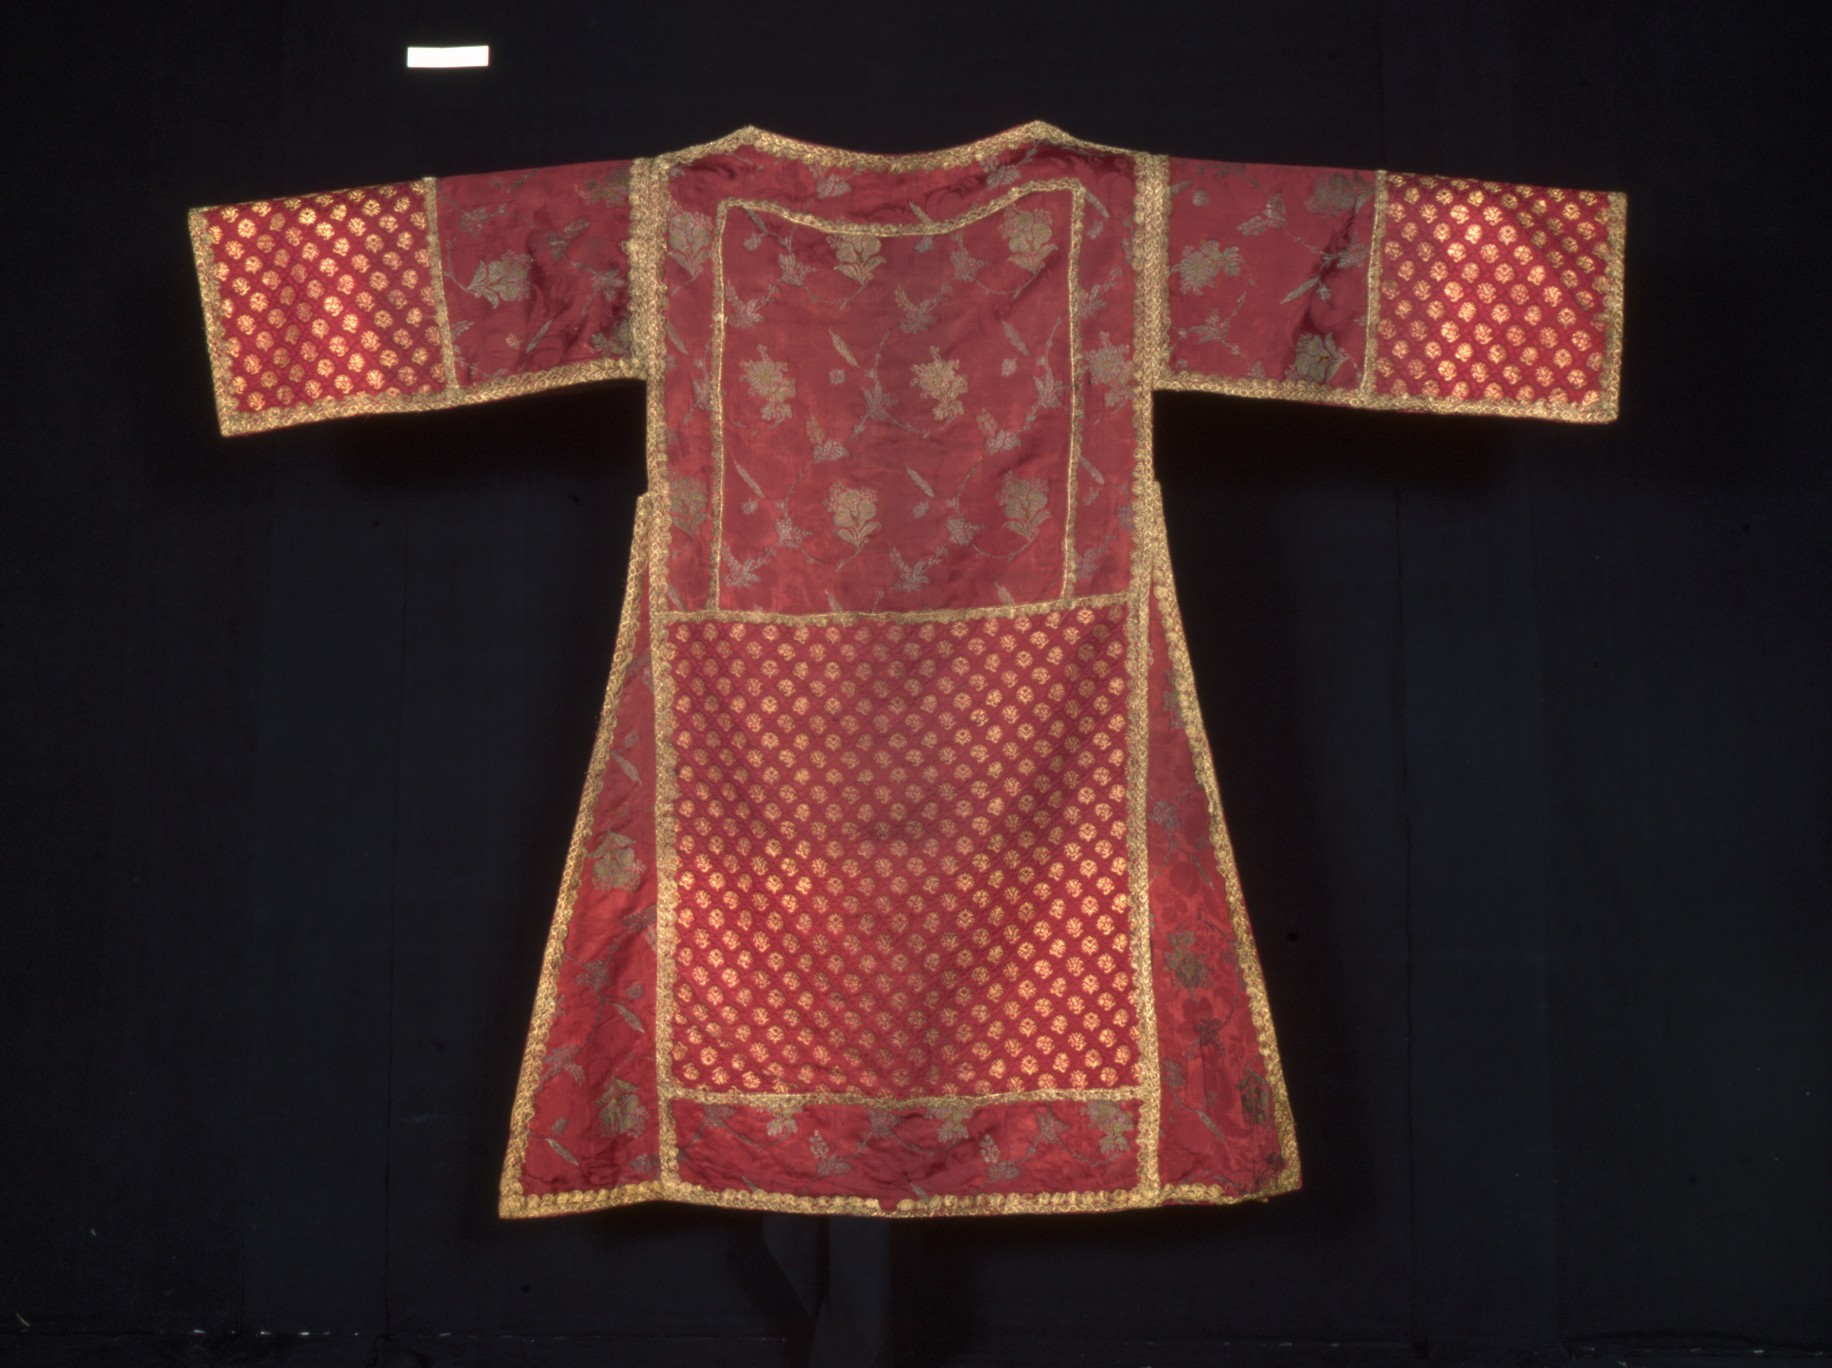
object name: dalmatic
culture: italian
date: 1601-1733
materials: metal, textile, silk